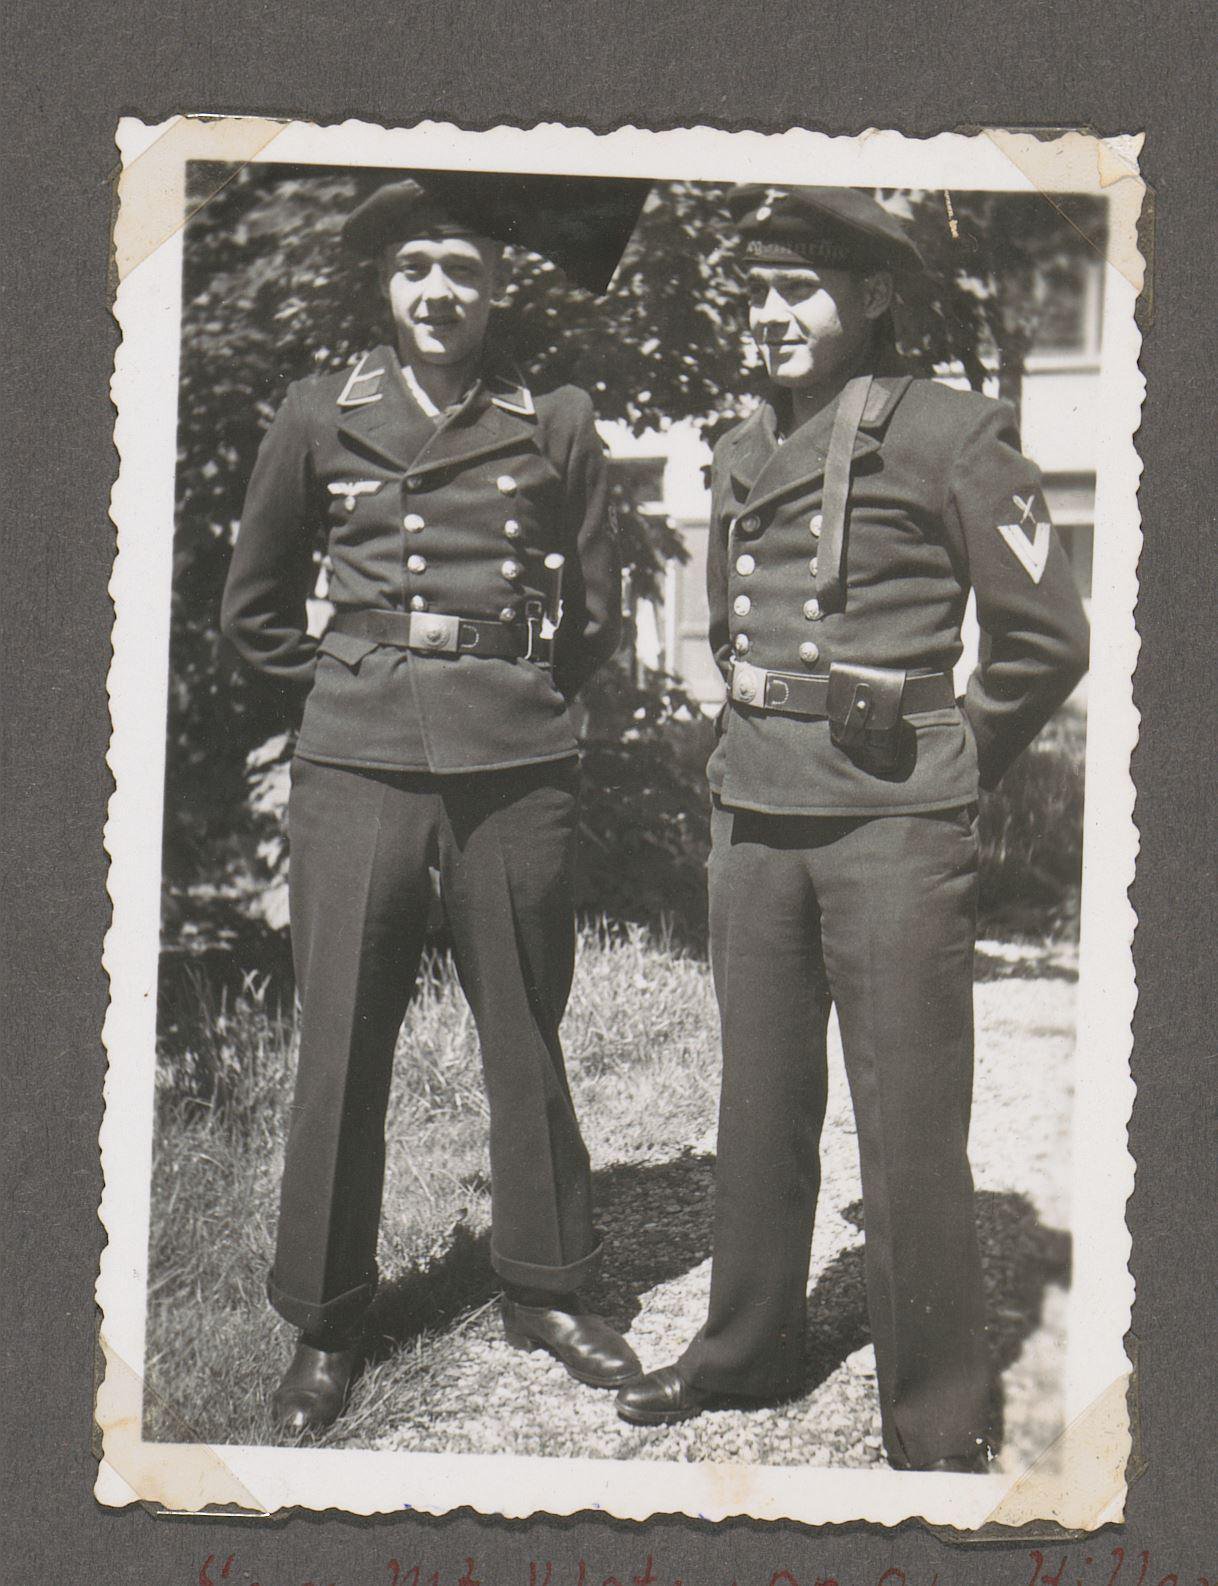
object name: album leaf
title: Sein Mt. Klotg + Ob. gfr Hiller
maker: Anonymous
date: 1941-1945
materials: paper, photographic support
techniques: gelatin silver print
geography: netherlands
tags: adult man, historical persons, occupation ~ war, military clothing and other equipment (uniforms, cap, armour, helmet, etc.), netherlands